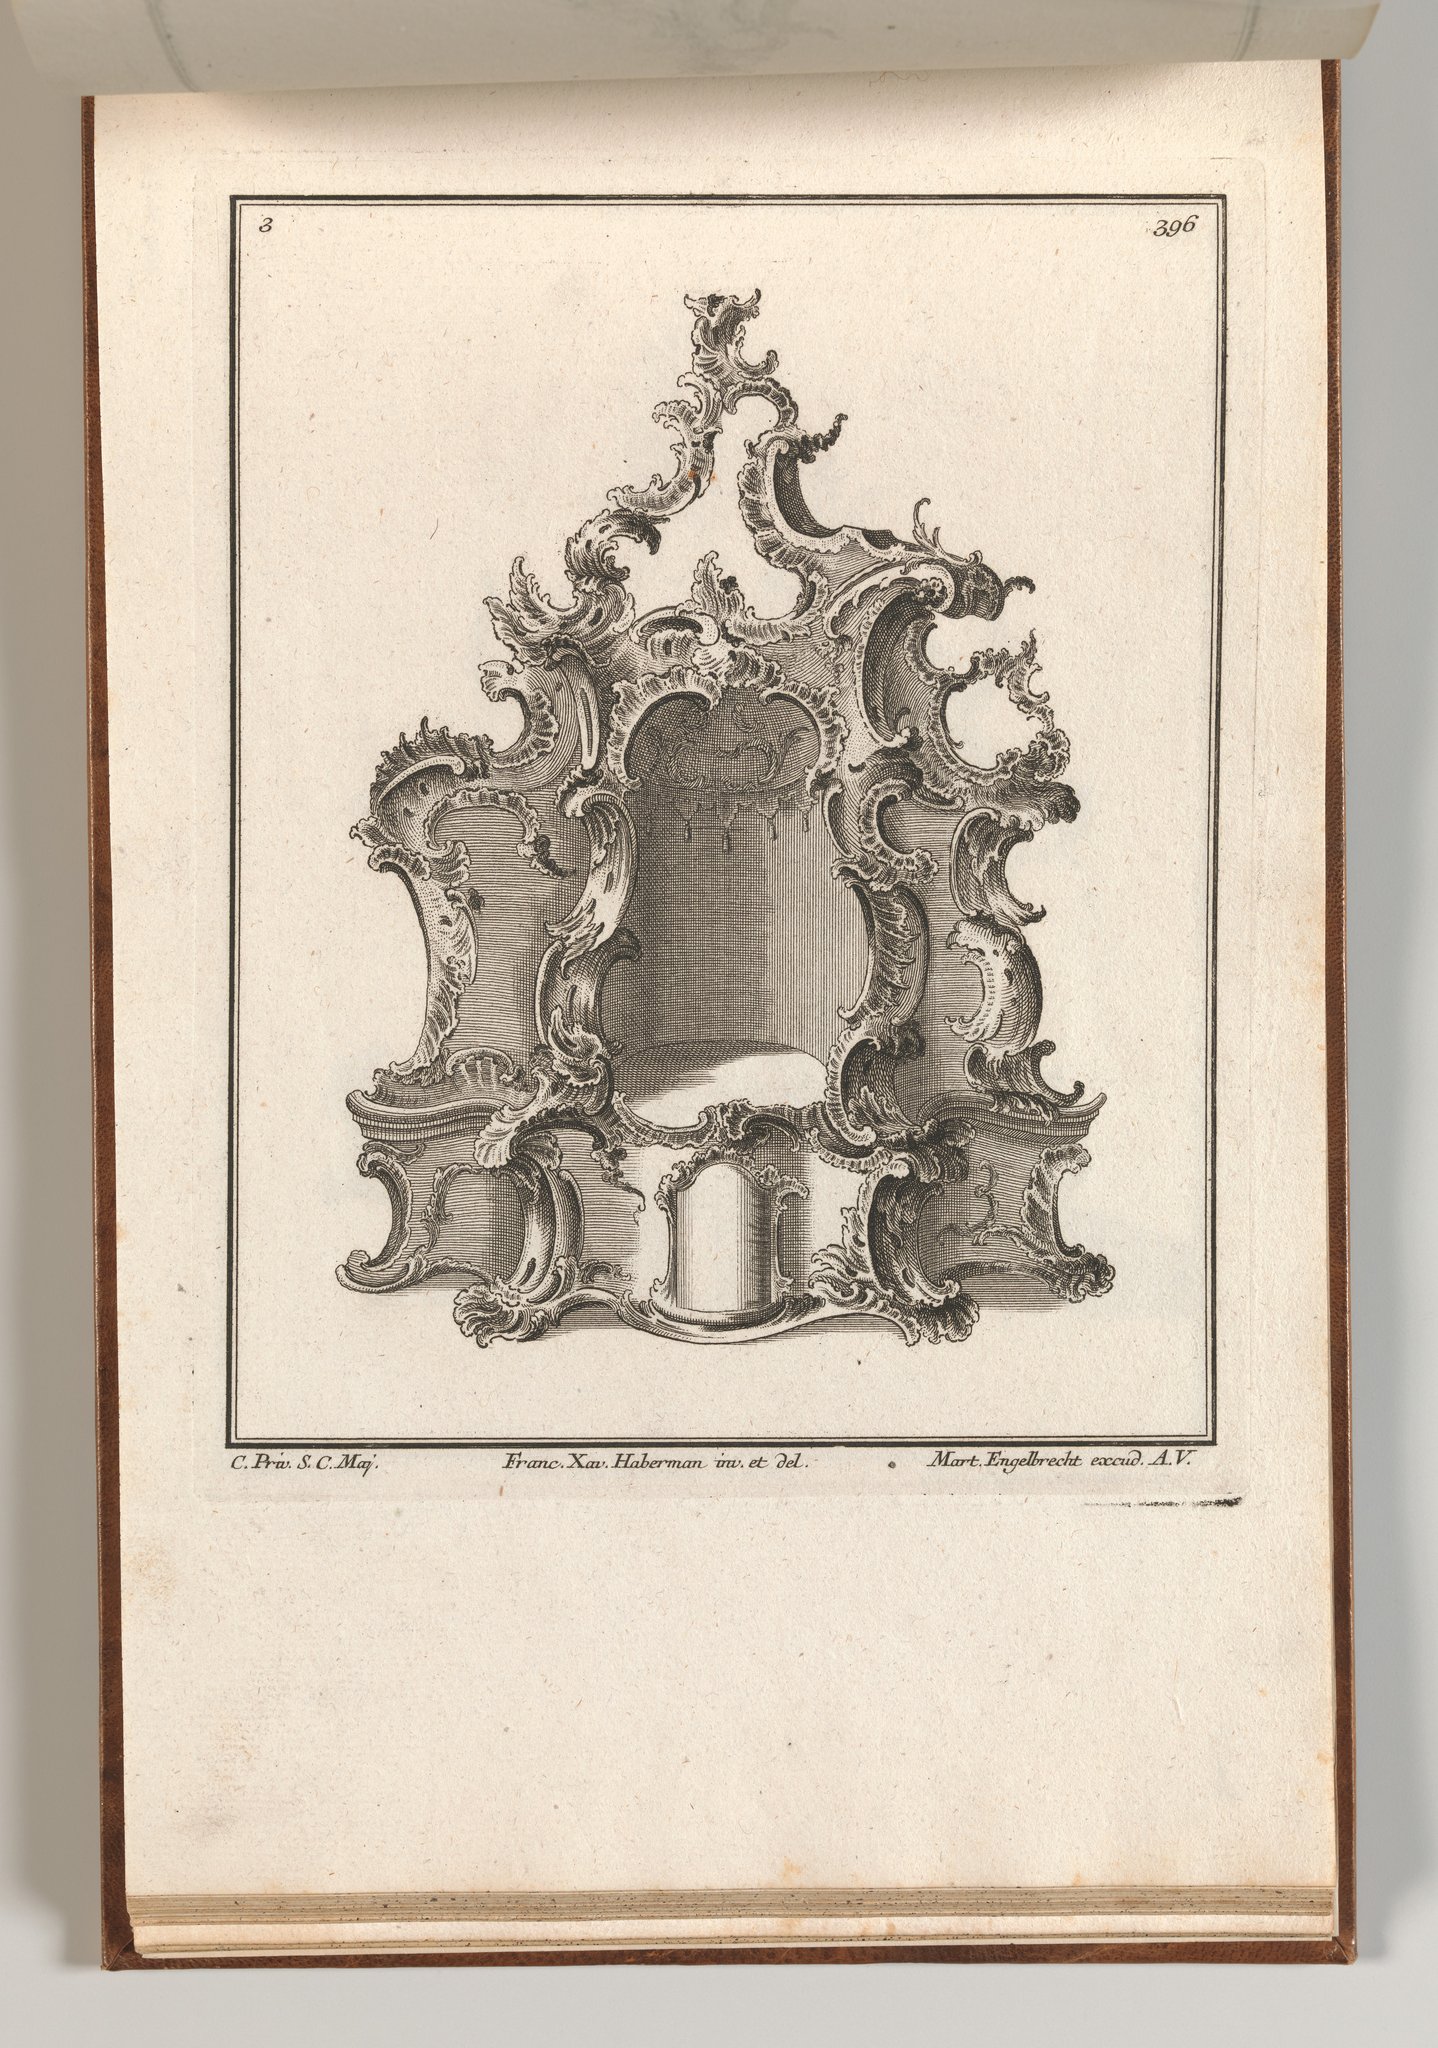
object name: album print ornament architecture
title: Design for a Tabernacle, Plate 3 from the series 'Tabernacle'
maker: franz xavier habermann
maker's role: artist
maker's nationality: german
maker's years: 1721-1796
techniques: etching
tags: tabernacles,ornament